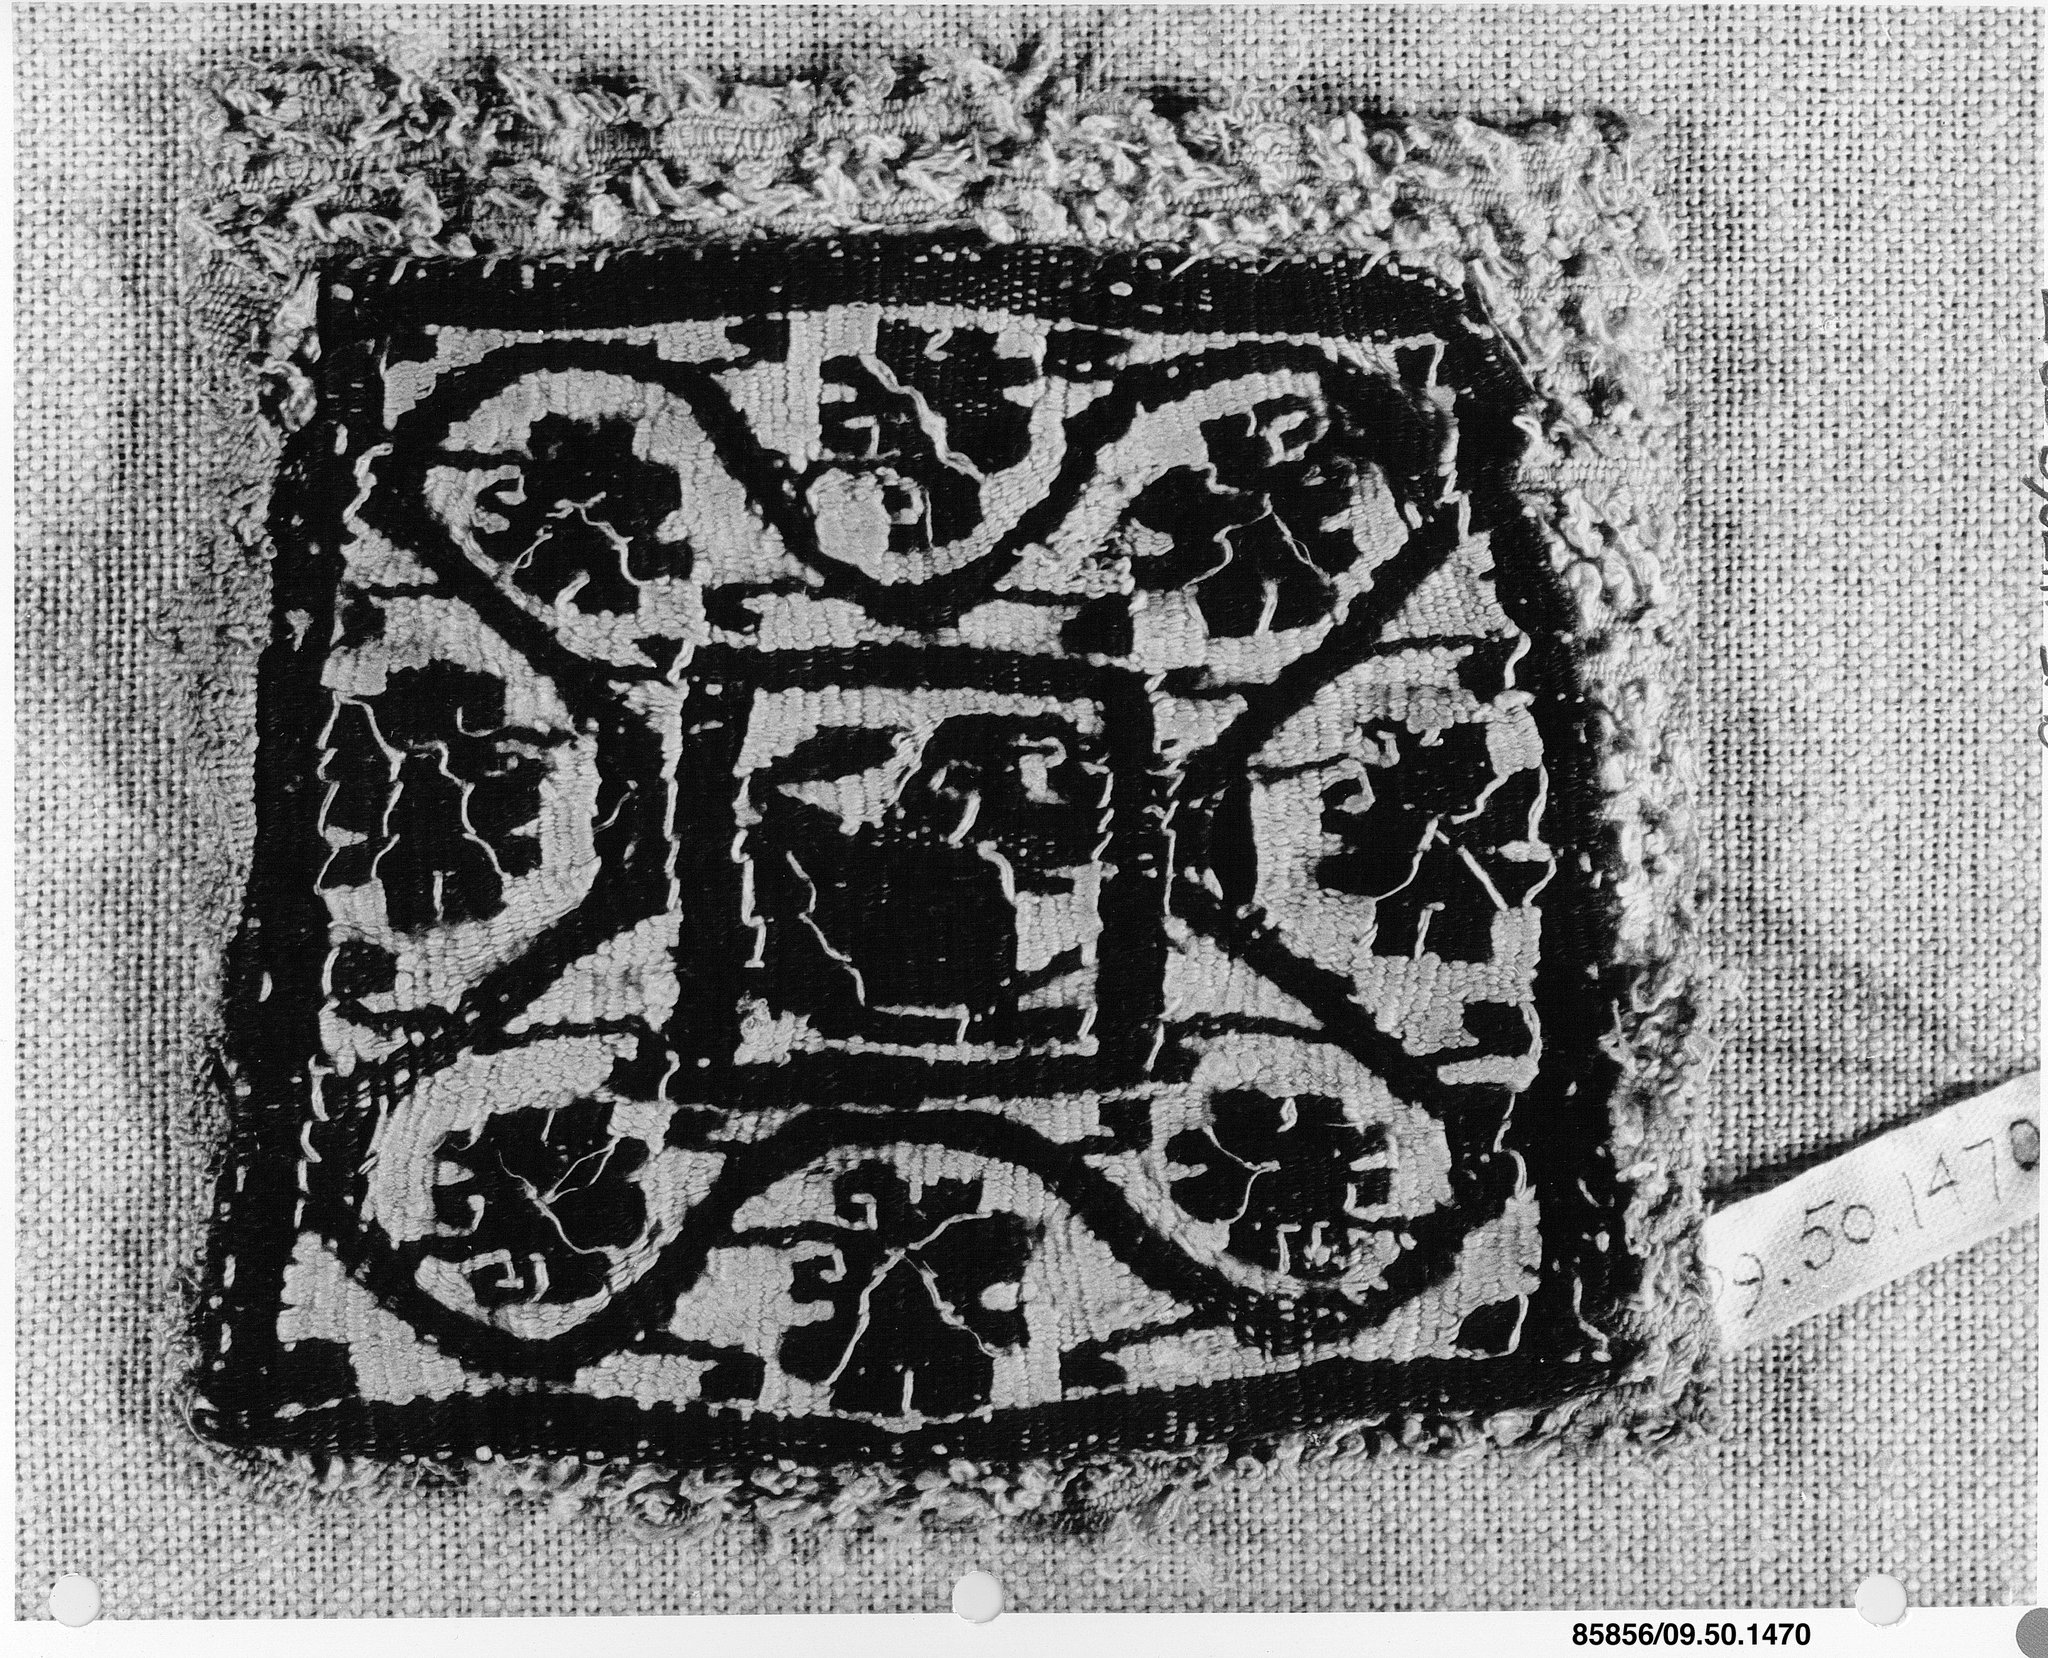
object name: square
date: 301-500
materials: linen, wool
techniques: embroidery, weave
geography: egypt